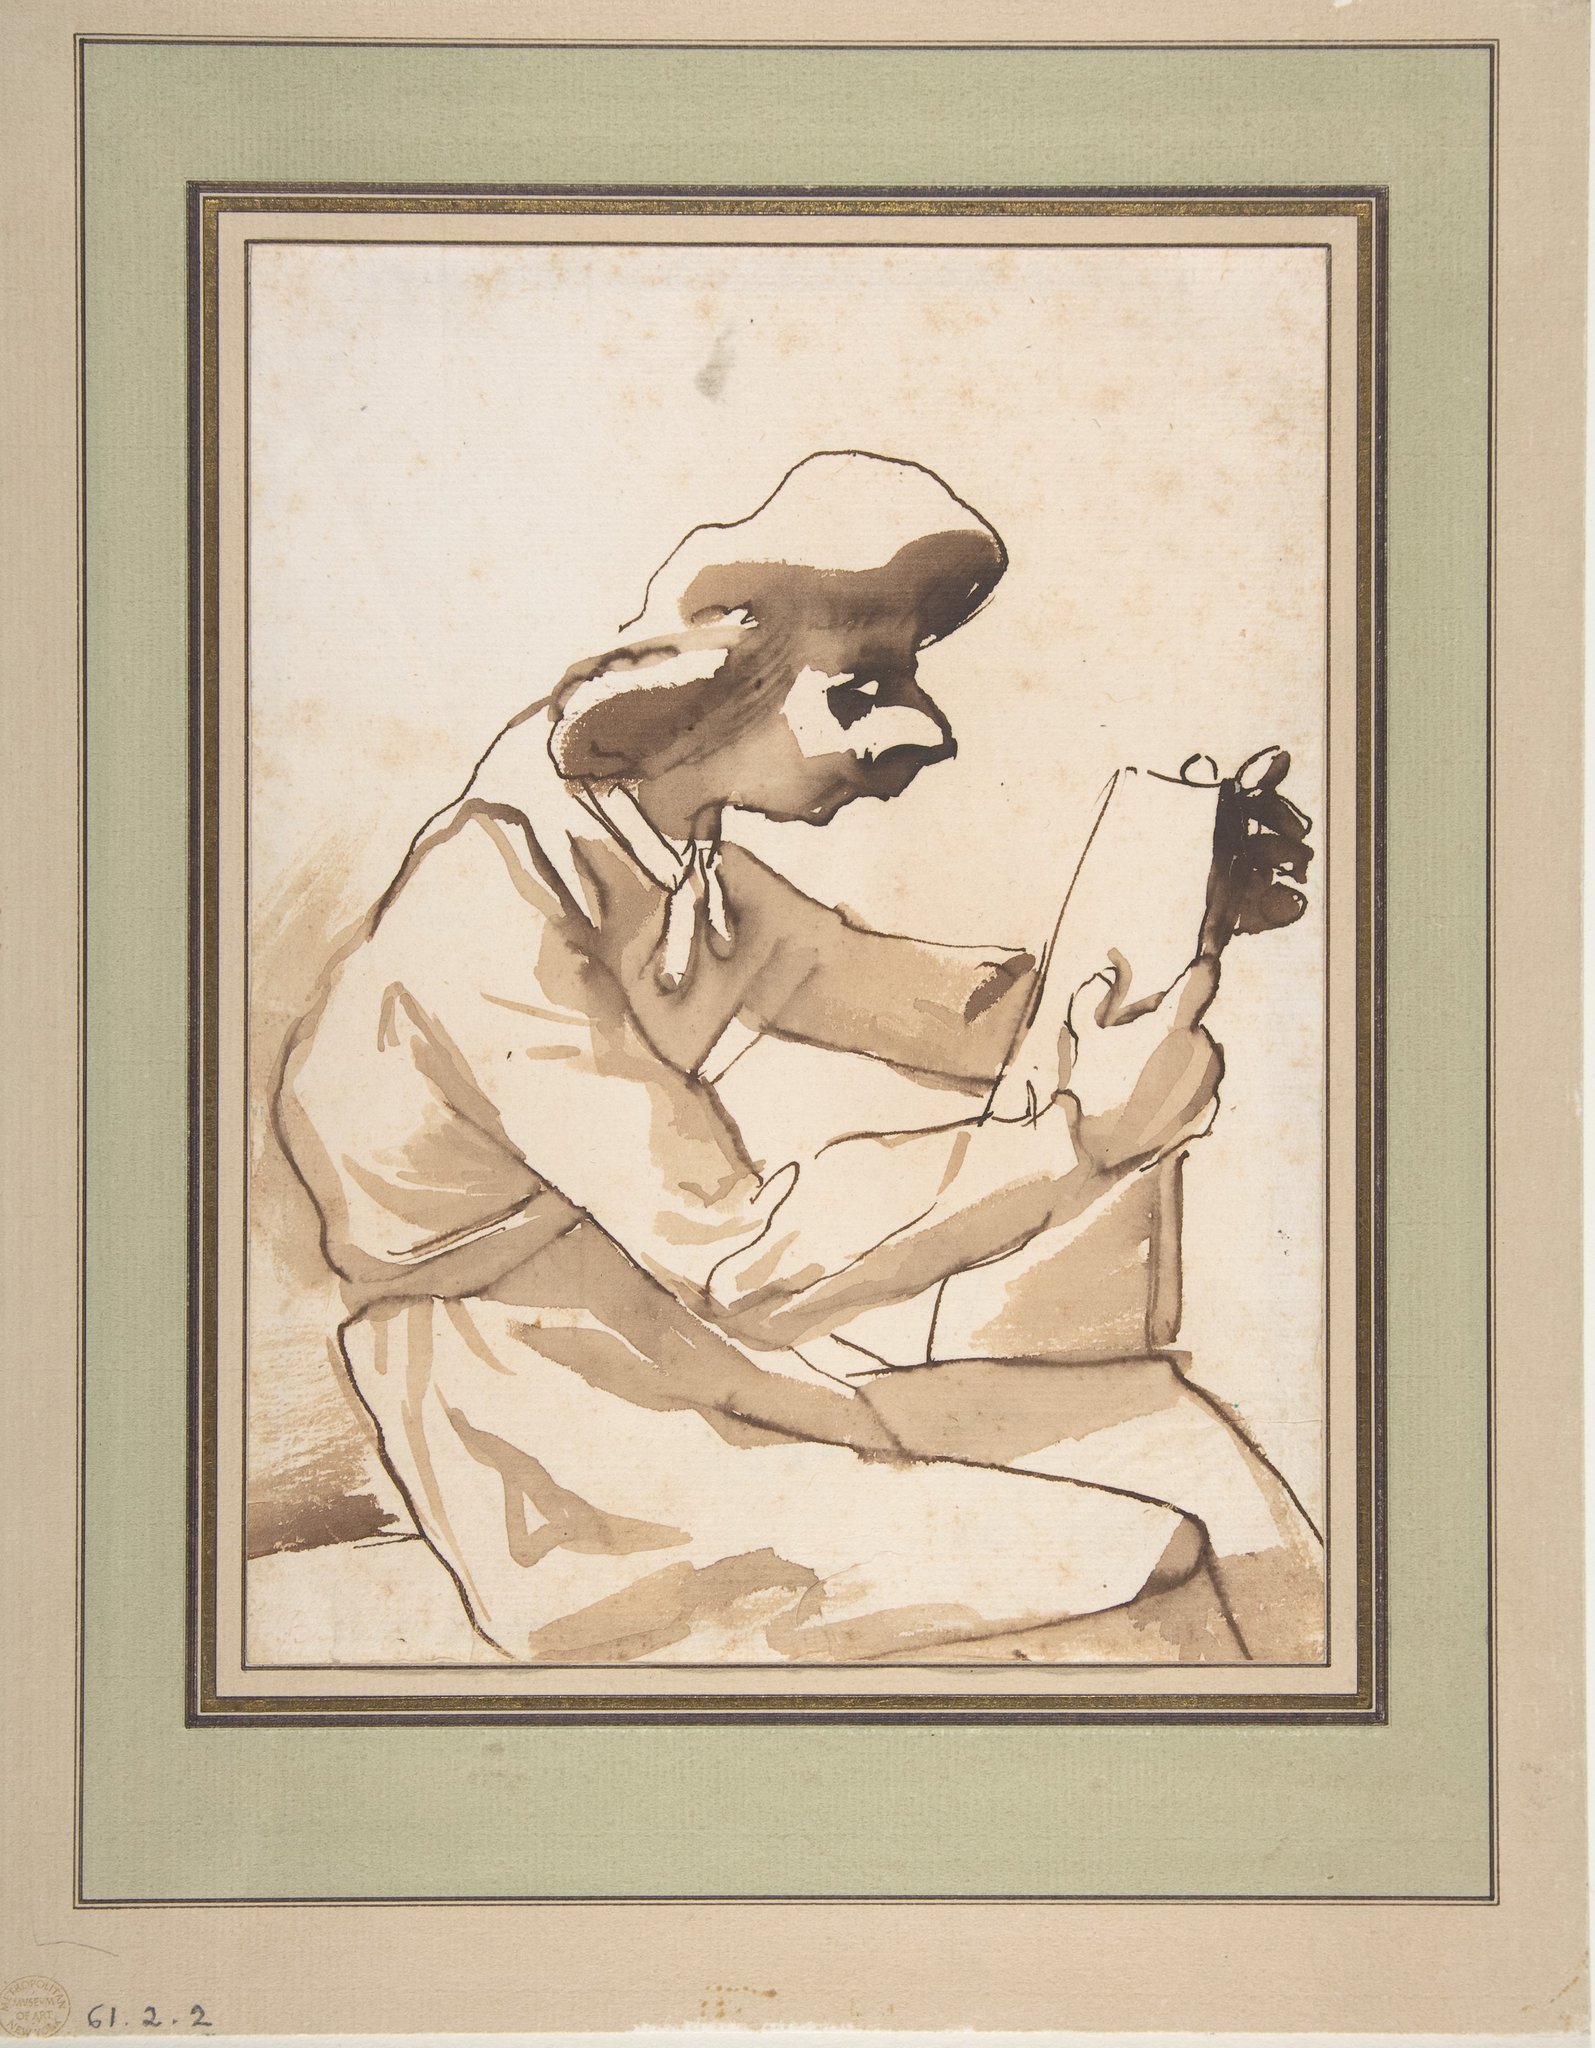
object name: drawing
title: Caricature of a Seated Man Reading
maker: pier francesco mola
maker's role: artist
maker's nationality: italian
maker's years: 1612-1666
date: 1612-1666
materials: ink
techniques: brush, pen, wash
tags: men,reading